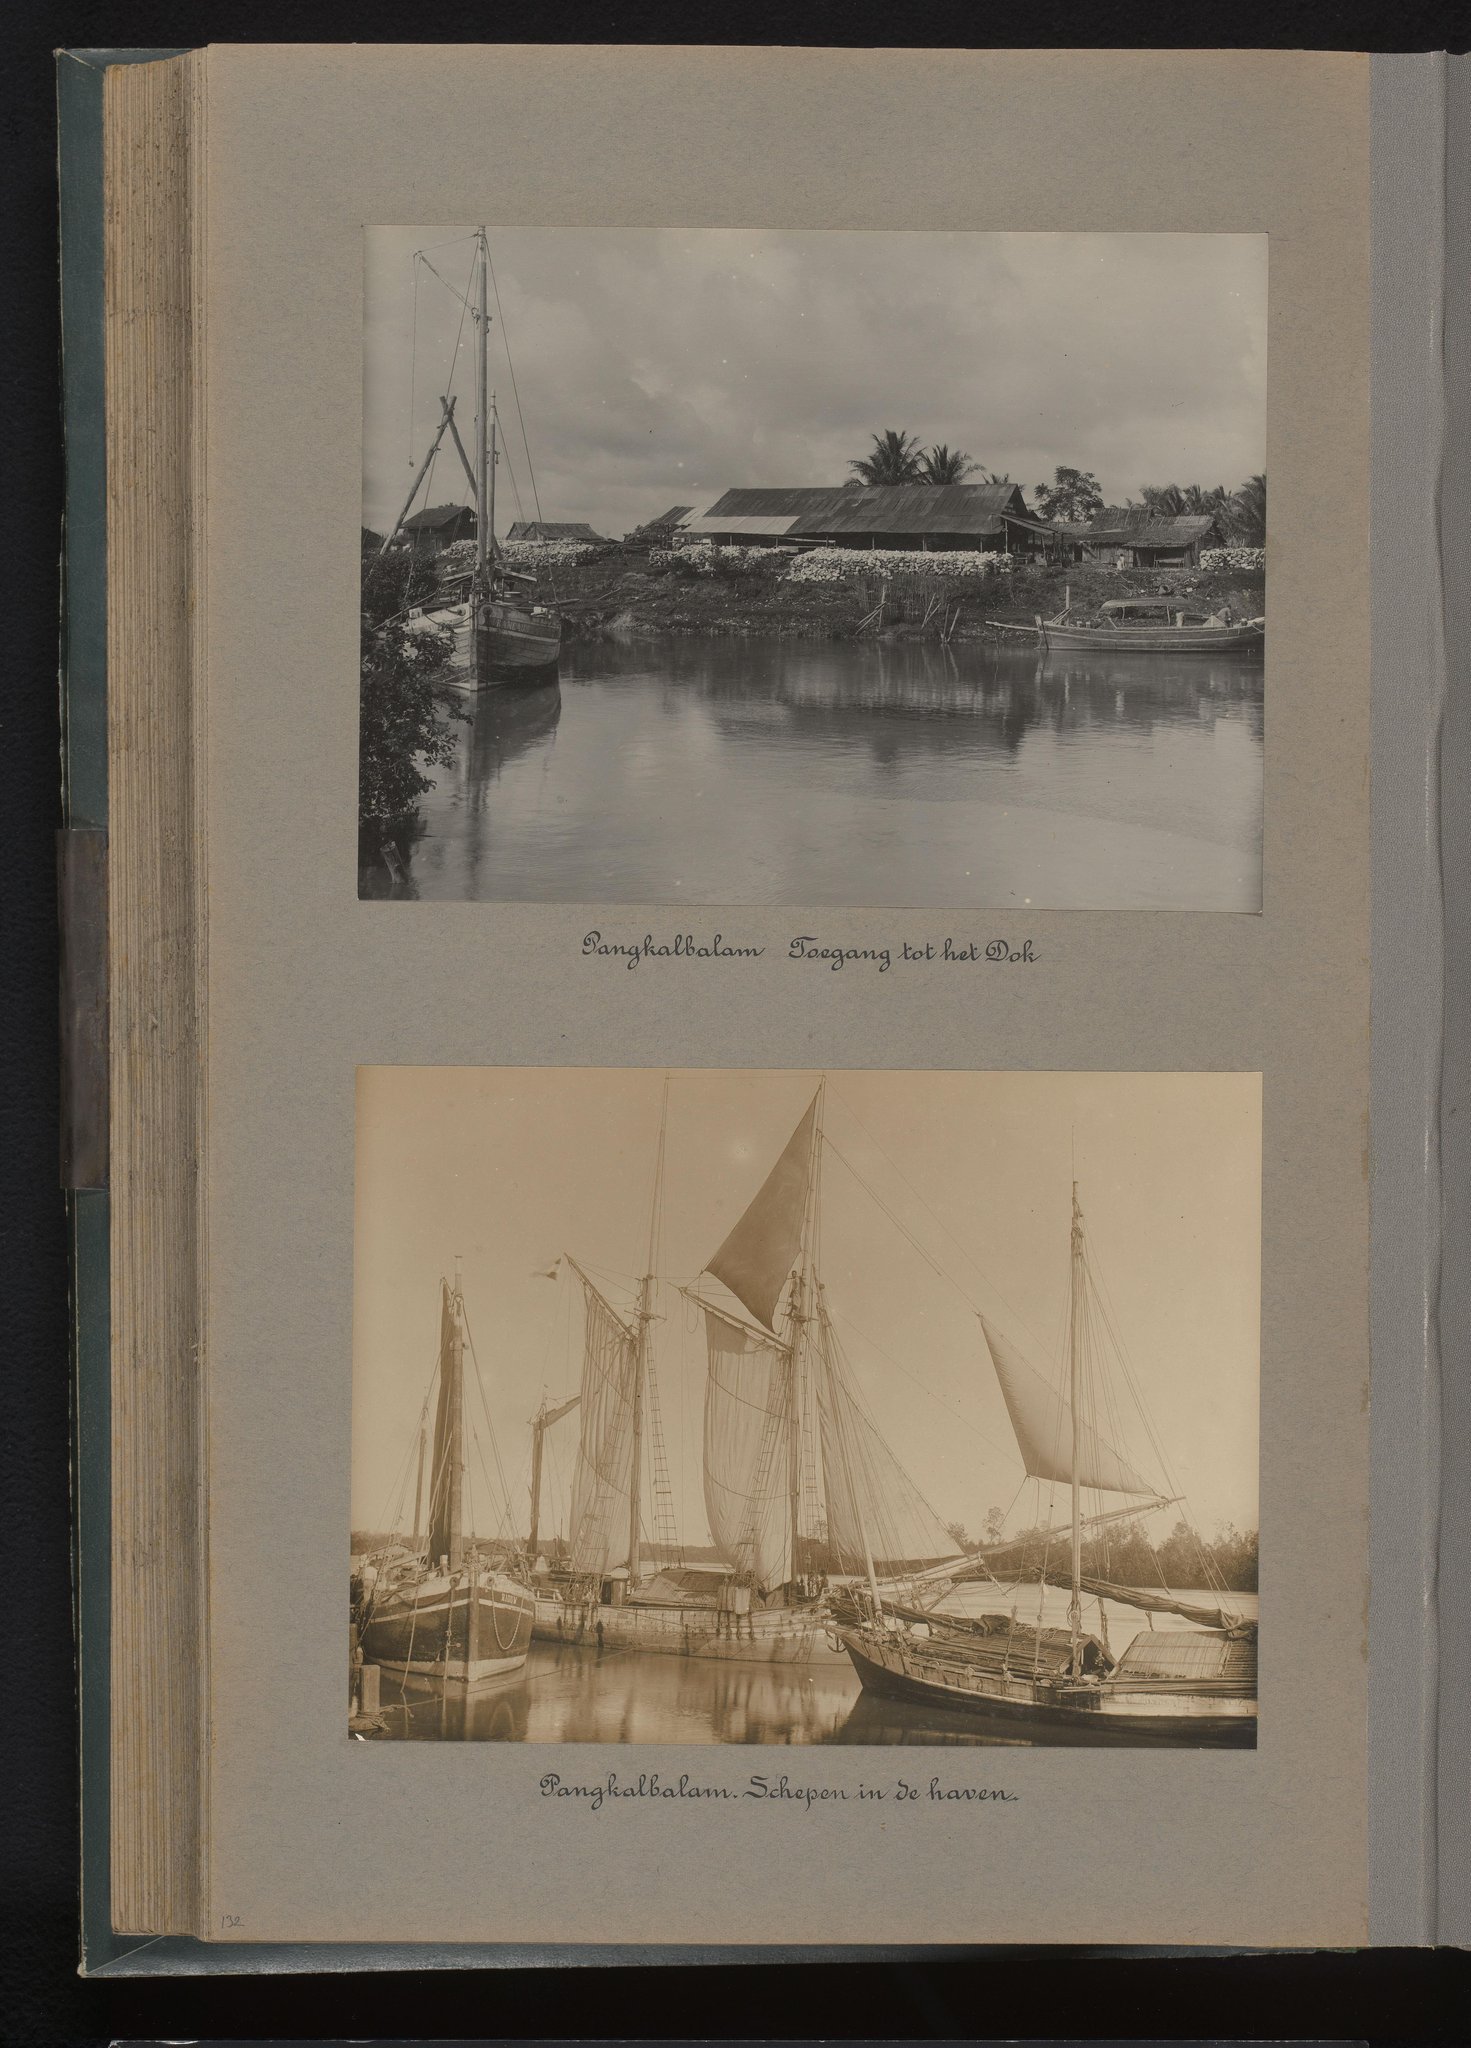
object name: photograph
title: Haven te Pangkalbalam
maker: Anonymous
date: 1914-1919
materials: cardboard, photographic support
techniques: gelatin silver print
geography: bangka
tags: robert julius boers, harbour, colonial system, mining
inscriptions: inscription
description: Albumblad met 2 foto's van schepen en dok in de haven van Pangkalbalam. Onderdeel van het fotoalbum aangeboden aan Robert Julius Boers bij zijn vertrek naar Nederland in 1919 door het personeel van de Banka-tinwinning.